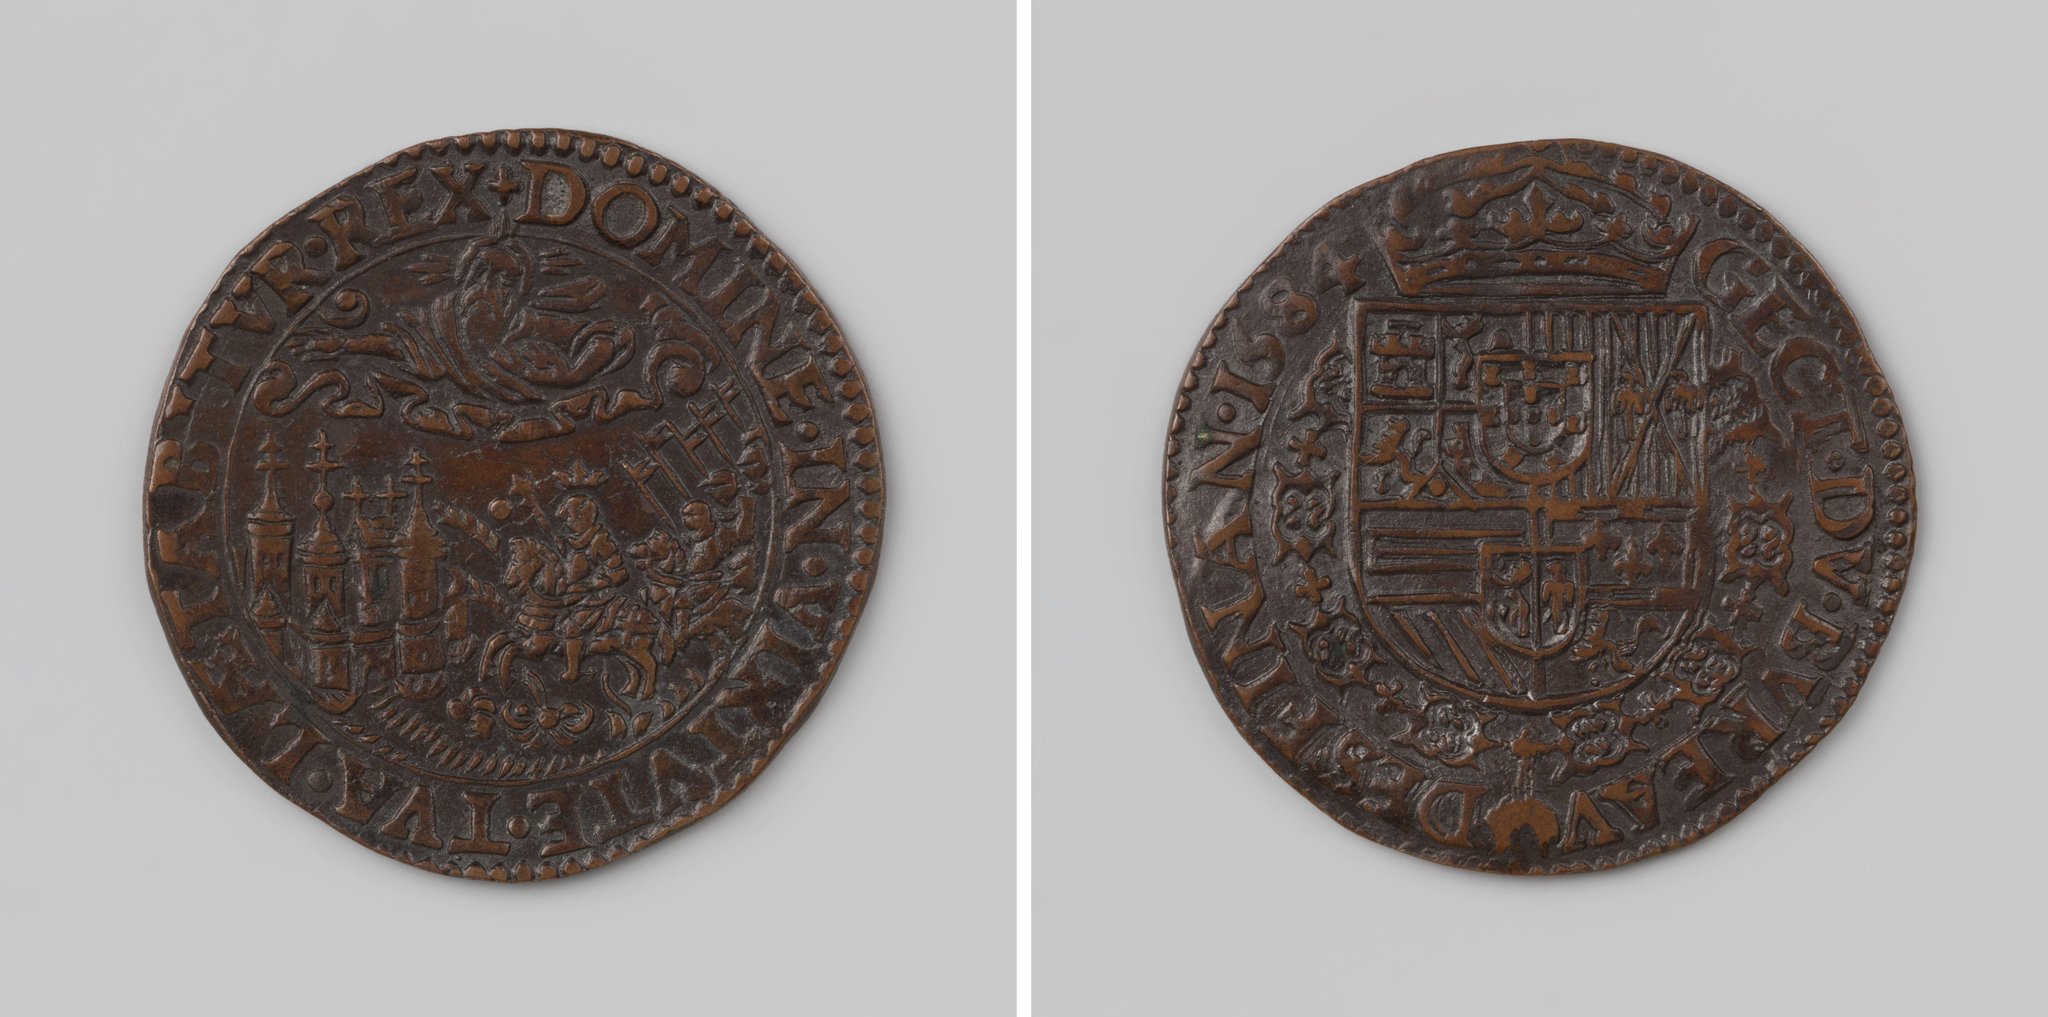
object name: jeton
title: Overwinningen van de Spaanse troepen in Vlaanderen, rekenpenning van de raad van Financien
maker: Anonymous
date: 1584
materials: copper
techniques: striking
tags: vienna, albert casimir van saksen-teschen, rome, alessandro farnese (landvoogd van de nederlanden en hertog van parma en piacenza)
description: Koperen penning. Voorzijde: groep ruiters, die in richting van stad rijdt; daarboven de Heer binnen omschrift. Keerzijde: gekroond wapenschild, omhangen met de orde van het Gulden Vlies binnen omschrift